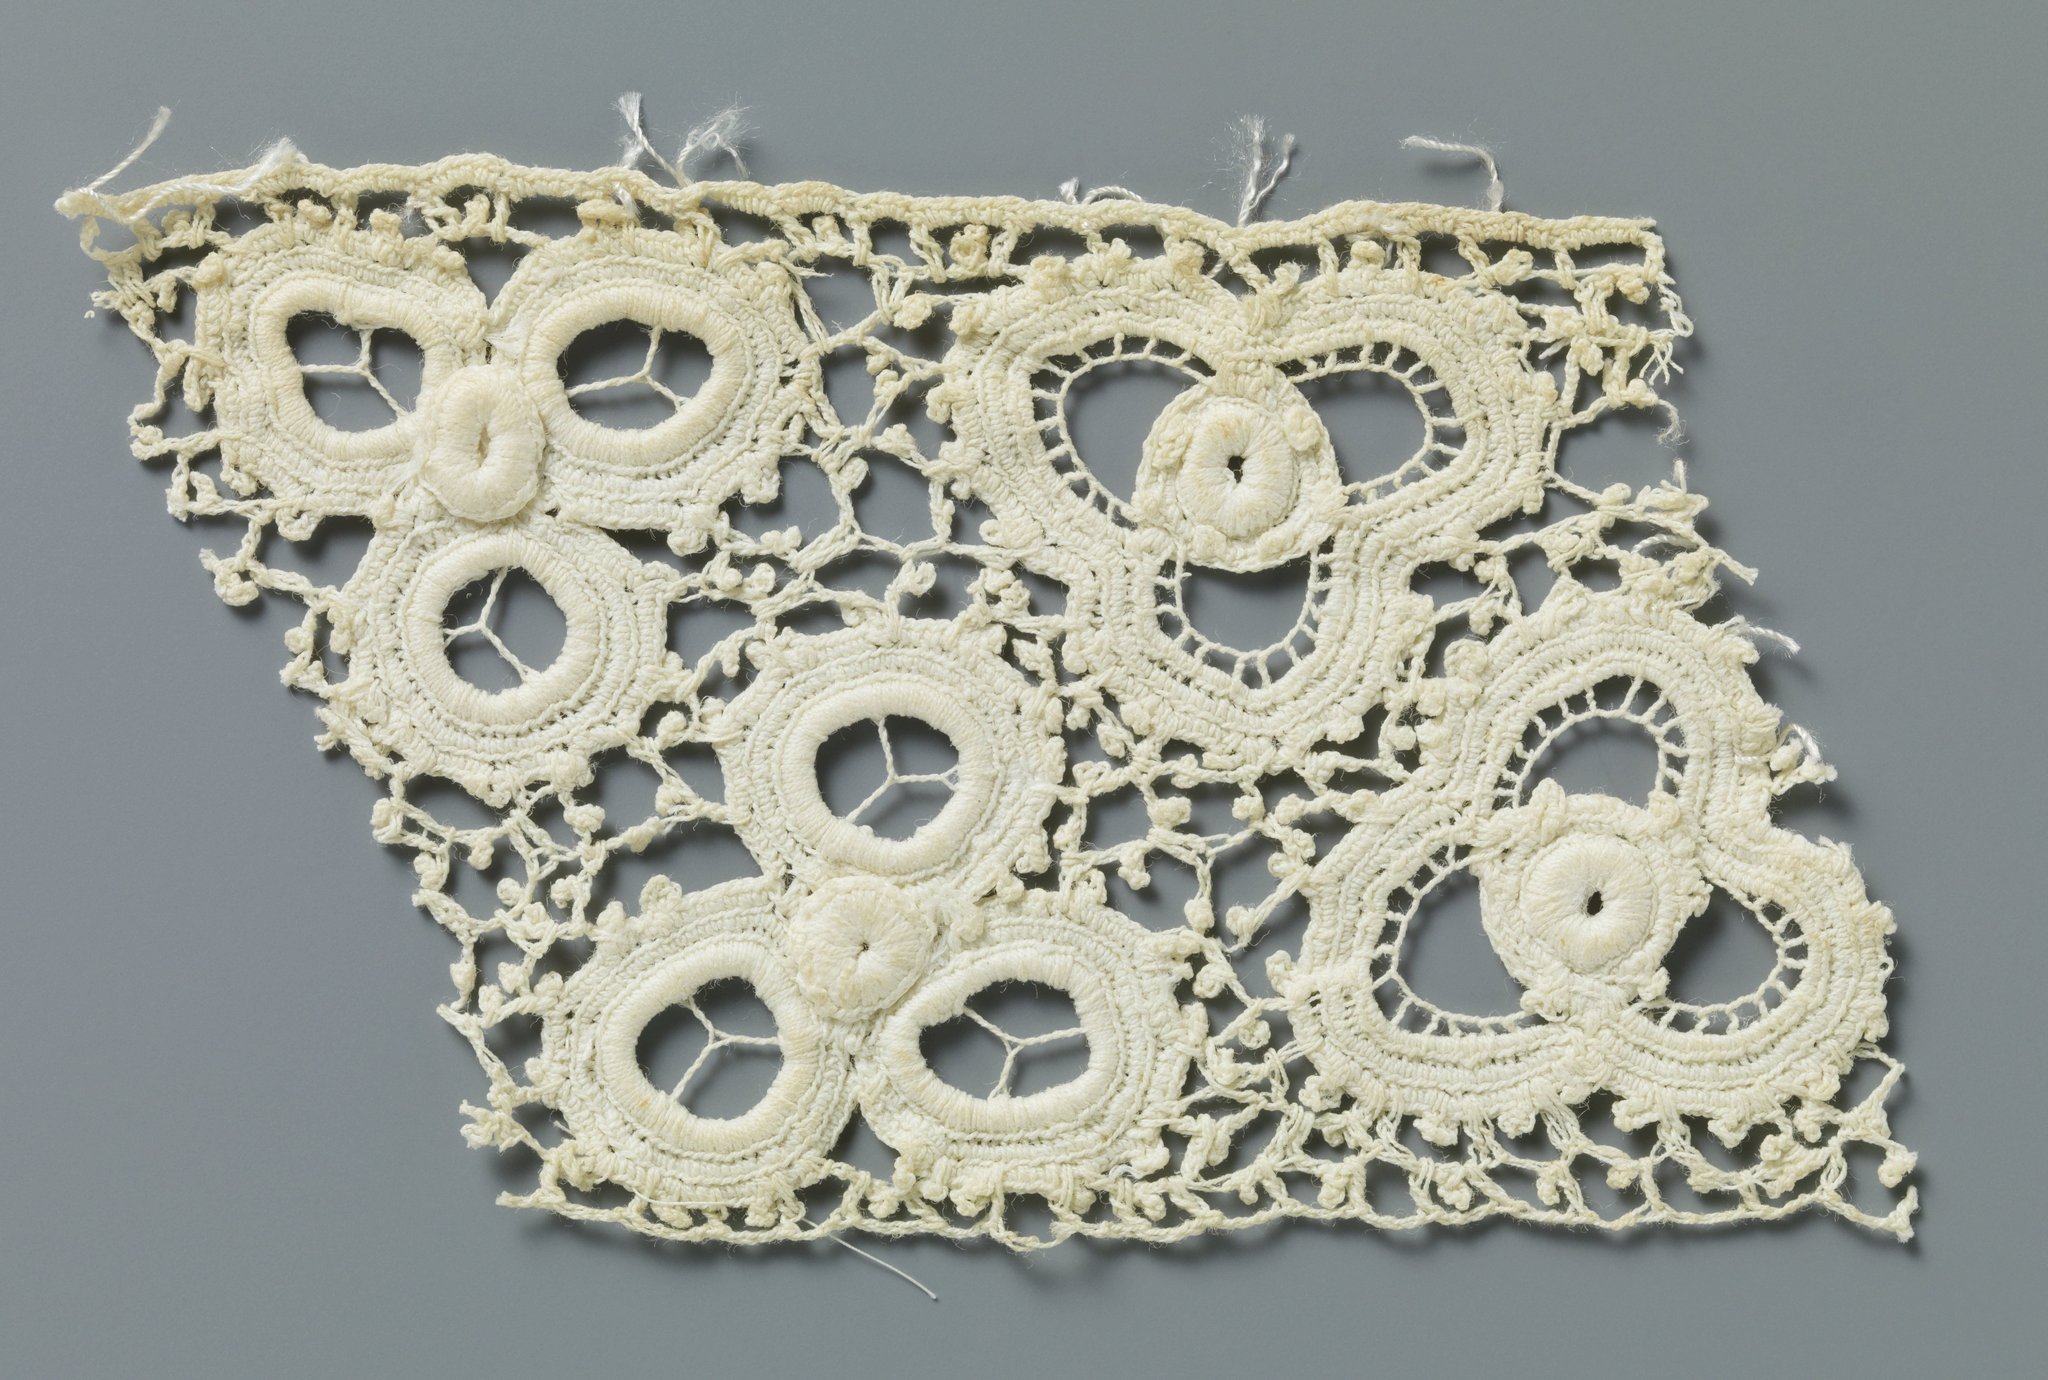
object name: strip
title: Strook gehaakte kant met vijfpuntige sterren en bloemen gemaakt met open cirkels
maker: Anonymous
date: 1890-1909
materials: cotton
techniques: crocheted lace, irish crochet lace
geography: ireland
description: Het is een aanname dat deze Ierse gehaakte kant ook daadwerkelijk in Ierland is gemaakt. Ierse gehaakte kant kent zijn oorsprong rond 1760 en kwam vanaf 1840 in ontwikkeling. Aangezien volgens Martine Bruggeman (Kant in Europa) de Ierse haakindustrie aan het eind van de 19e eeuw gereorganiseerd werd en in populariteit groeide, is het hier beschreven stuk gedateerd rond 1890, tot 1909 vanwege de datering in het eerste decennium van populariteit van Ierse gehaakte kant volgens het Kantlexicon (Johan Coene).